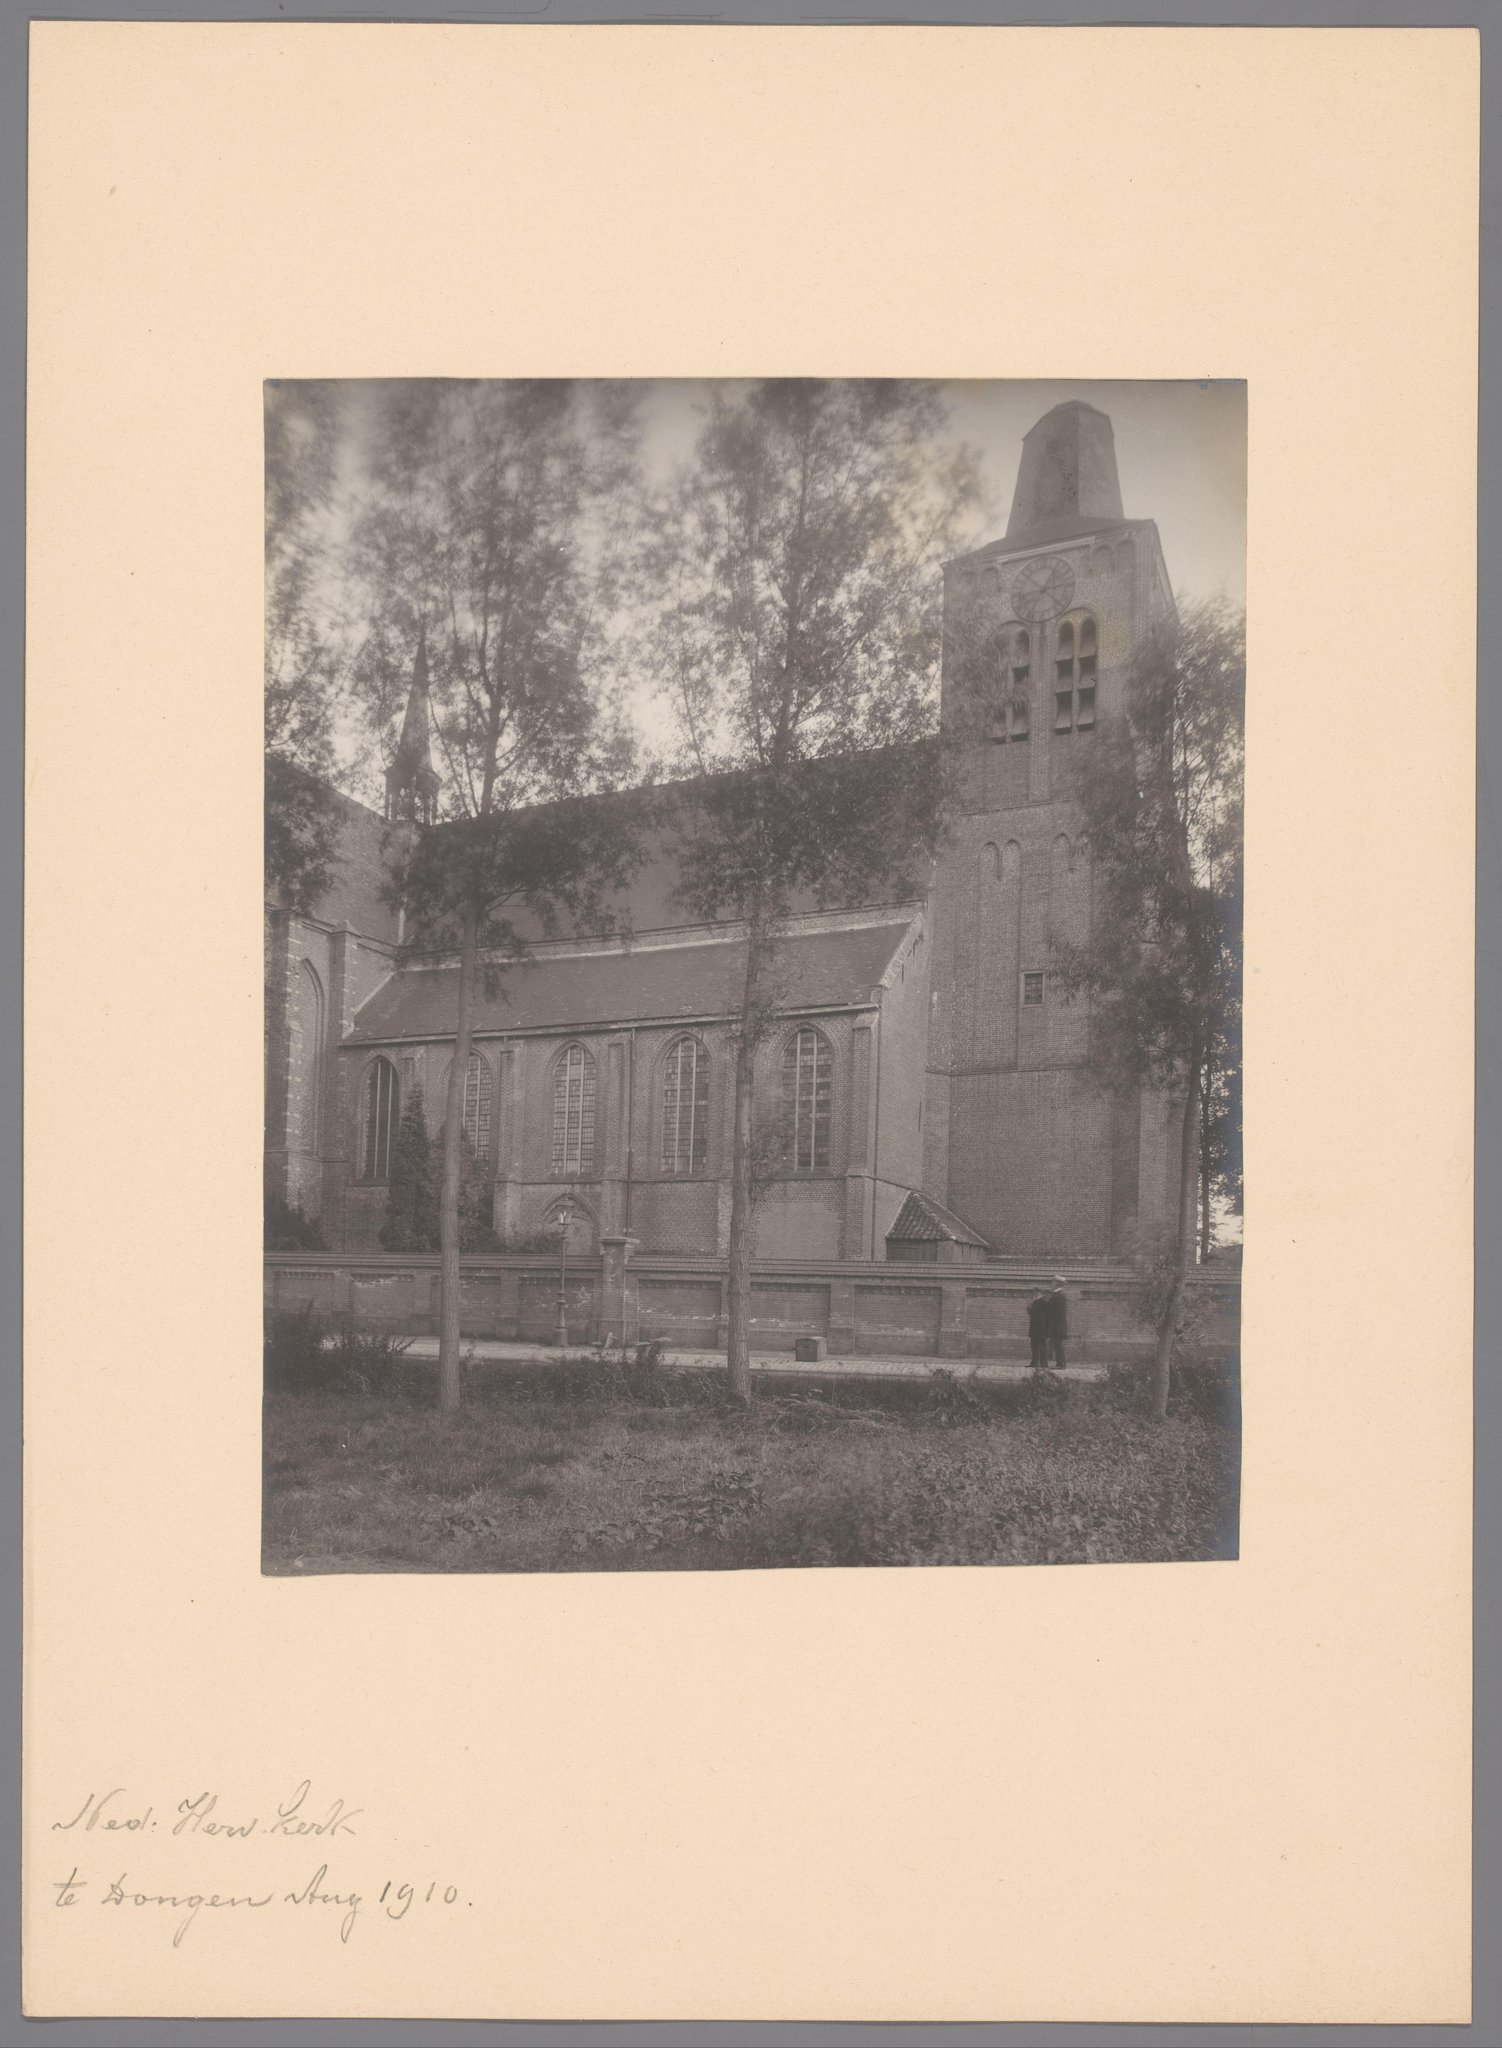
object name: photograph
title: Gezicht op de Hervormde Kerk te Dongen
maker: anoniem (monumentenzorg)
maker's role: fotograaf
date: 1910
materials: cardboard, photographic support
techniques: gelatin silver print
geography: dongen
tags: church (exterior)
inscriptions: annotation: ‘Ned. Herv. kerk te Dongen Aug: 1910’